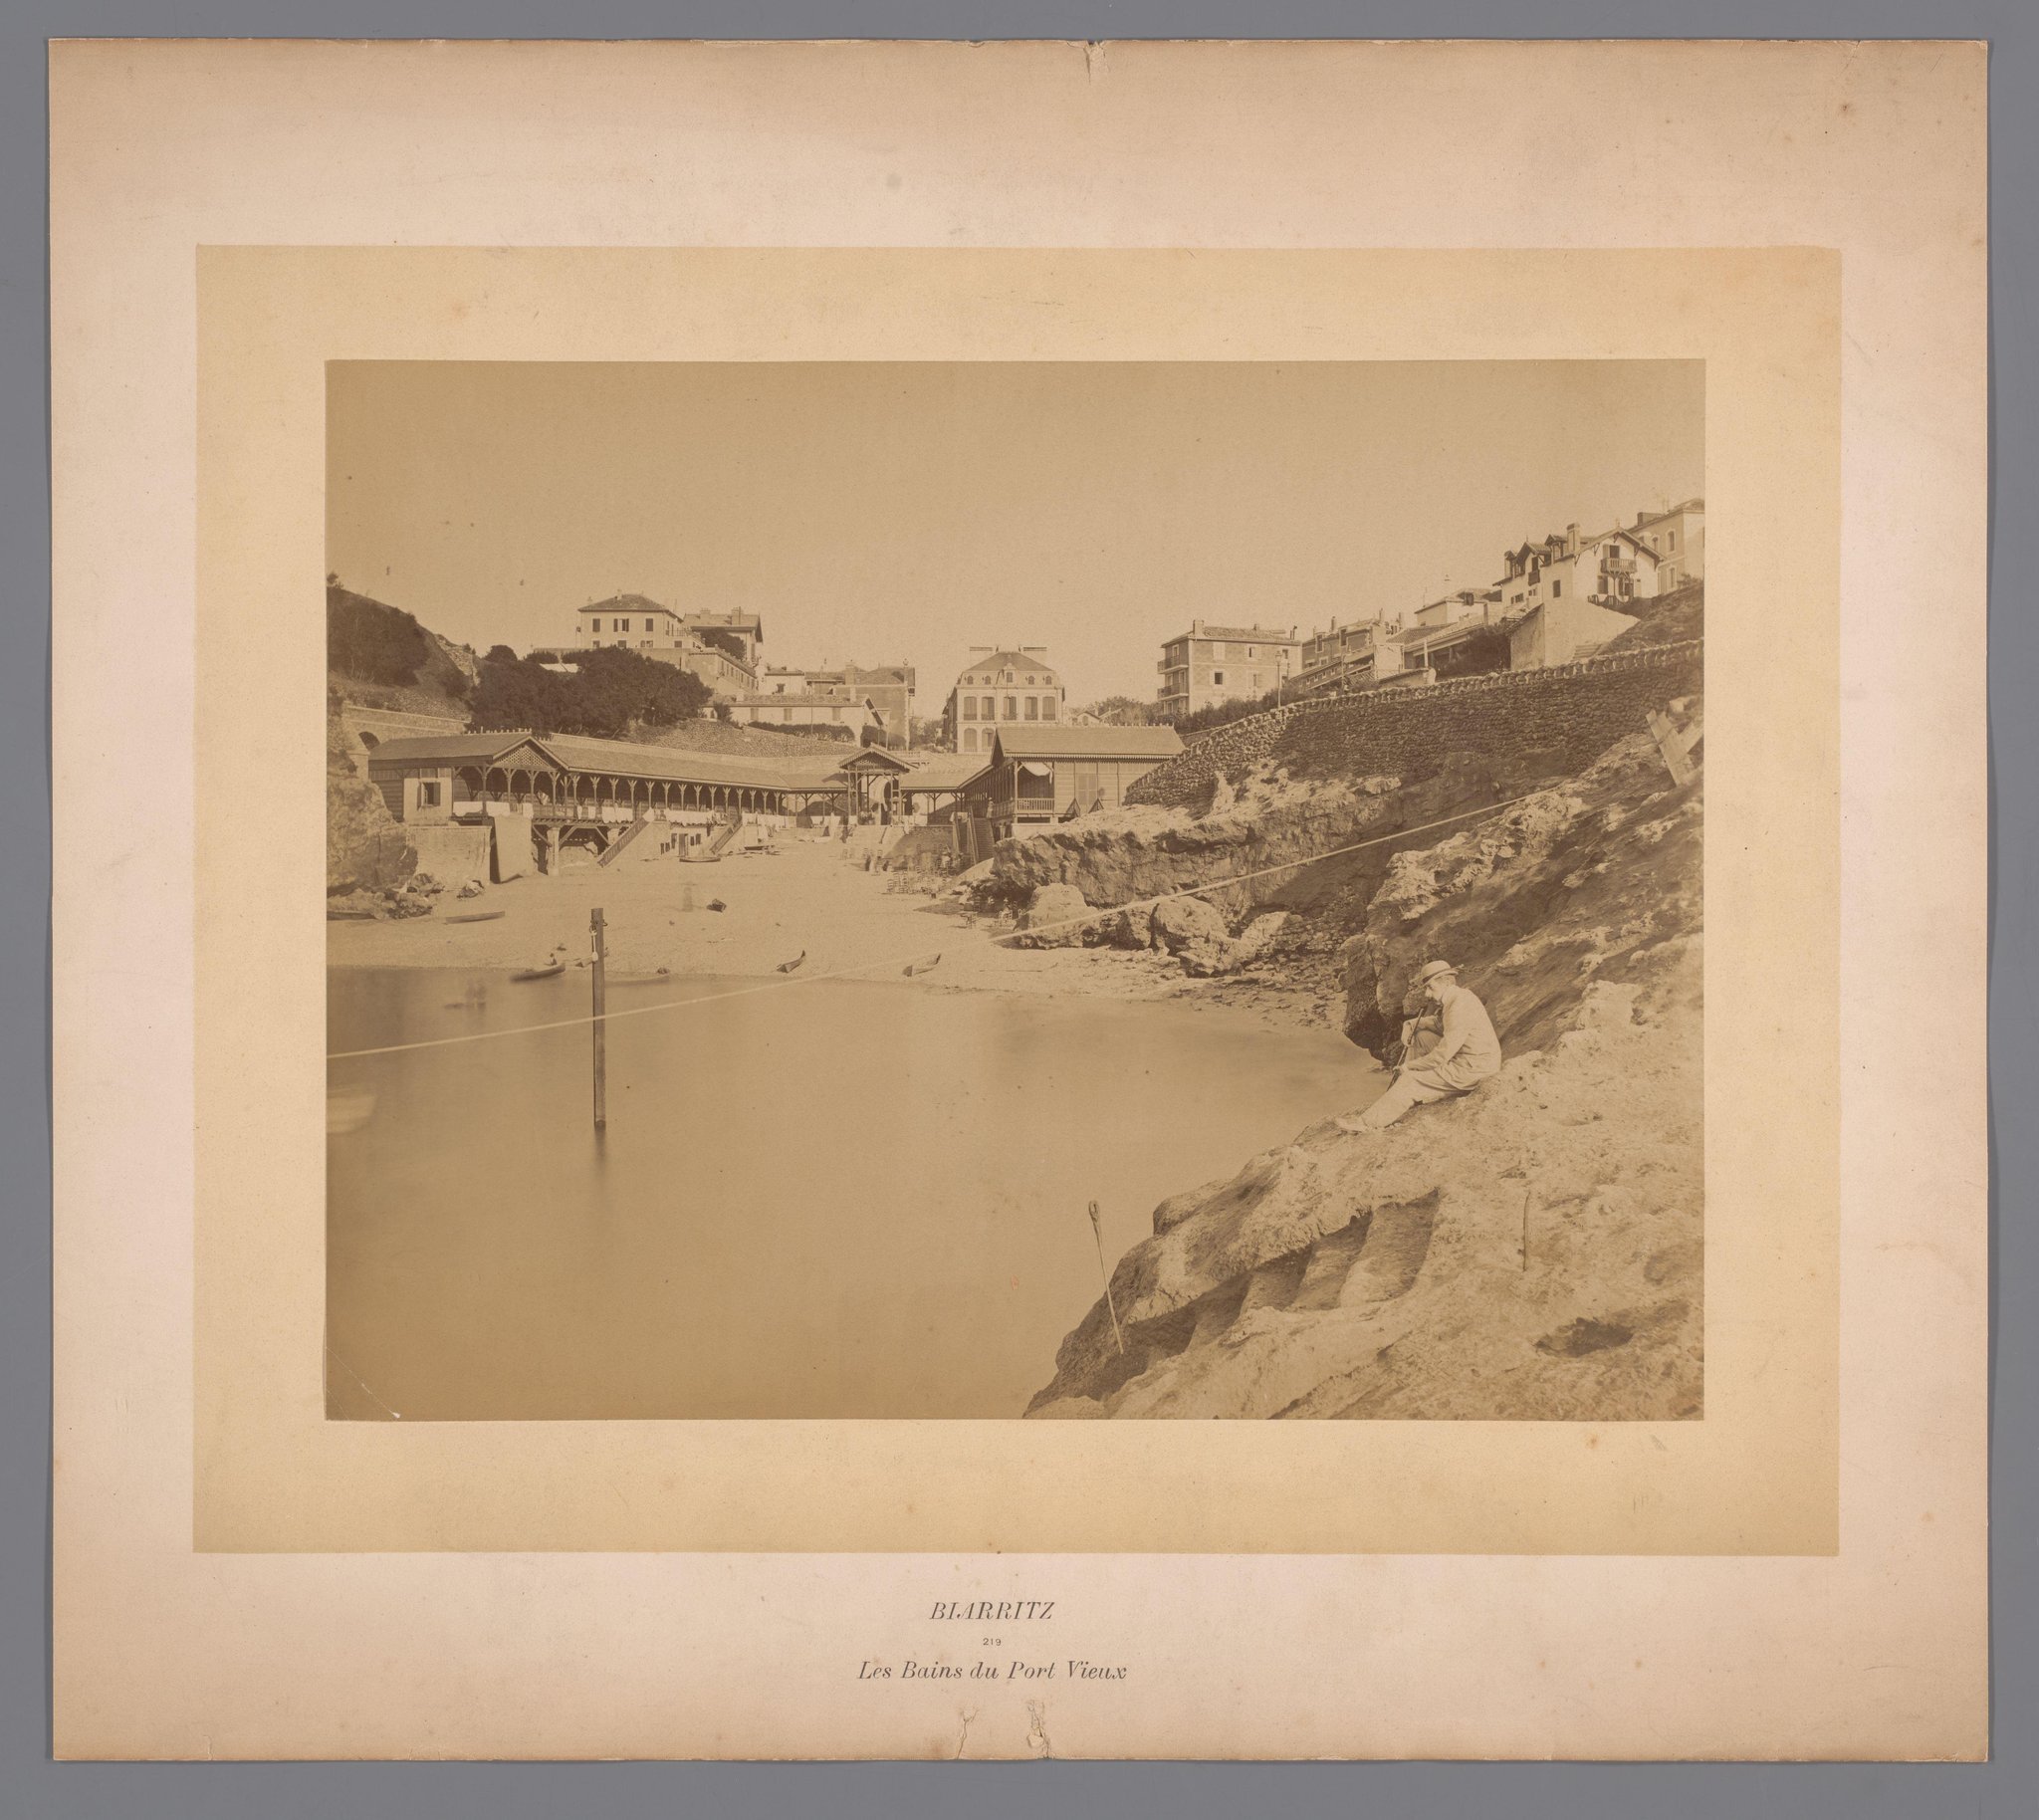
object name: photograph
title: "Biarritz. Les Bains du Port Vieux", Frankrijk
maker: Anonymous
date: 1880-1900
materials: cardboard, paper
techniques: albumen print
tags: biarritz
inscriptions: caption: ‘BIARRITZ//219// Les Bains du Port Vieux’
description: Uitzicht op oude haven van Biarritz, met rechts een zittende man met wandelstok.